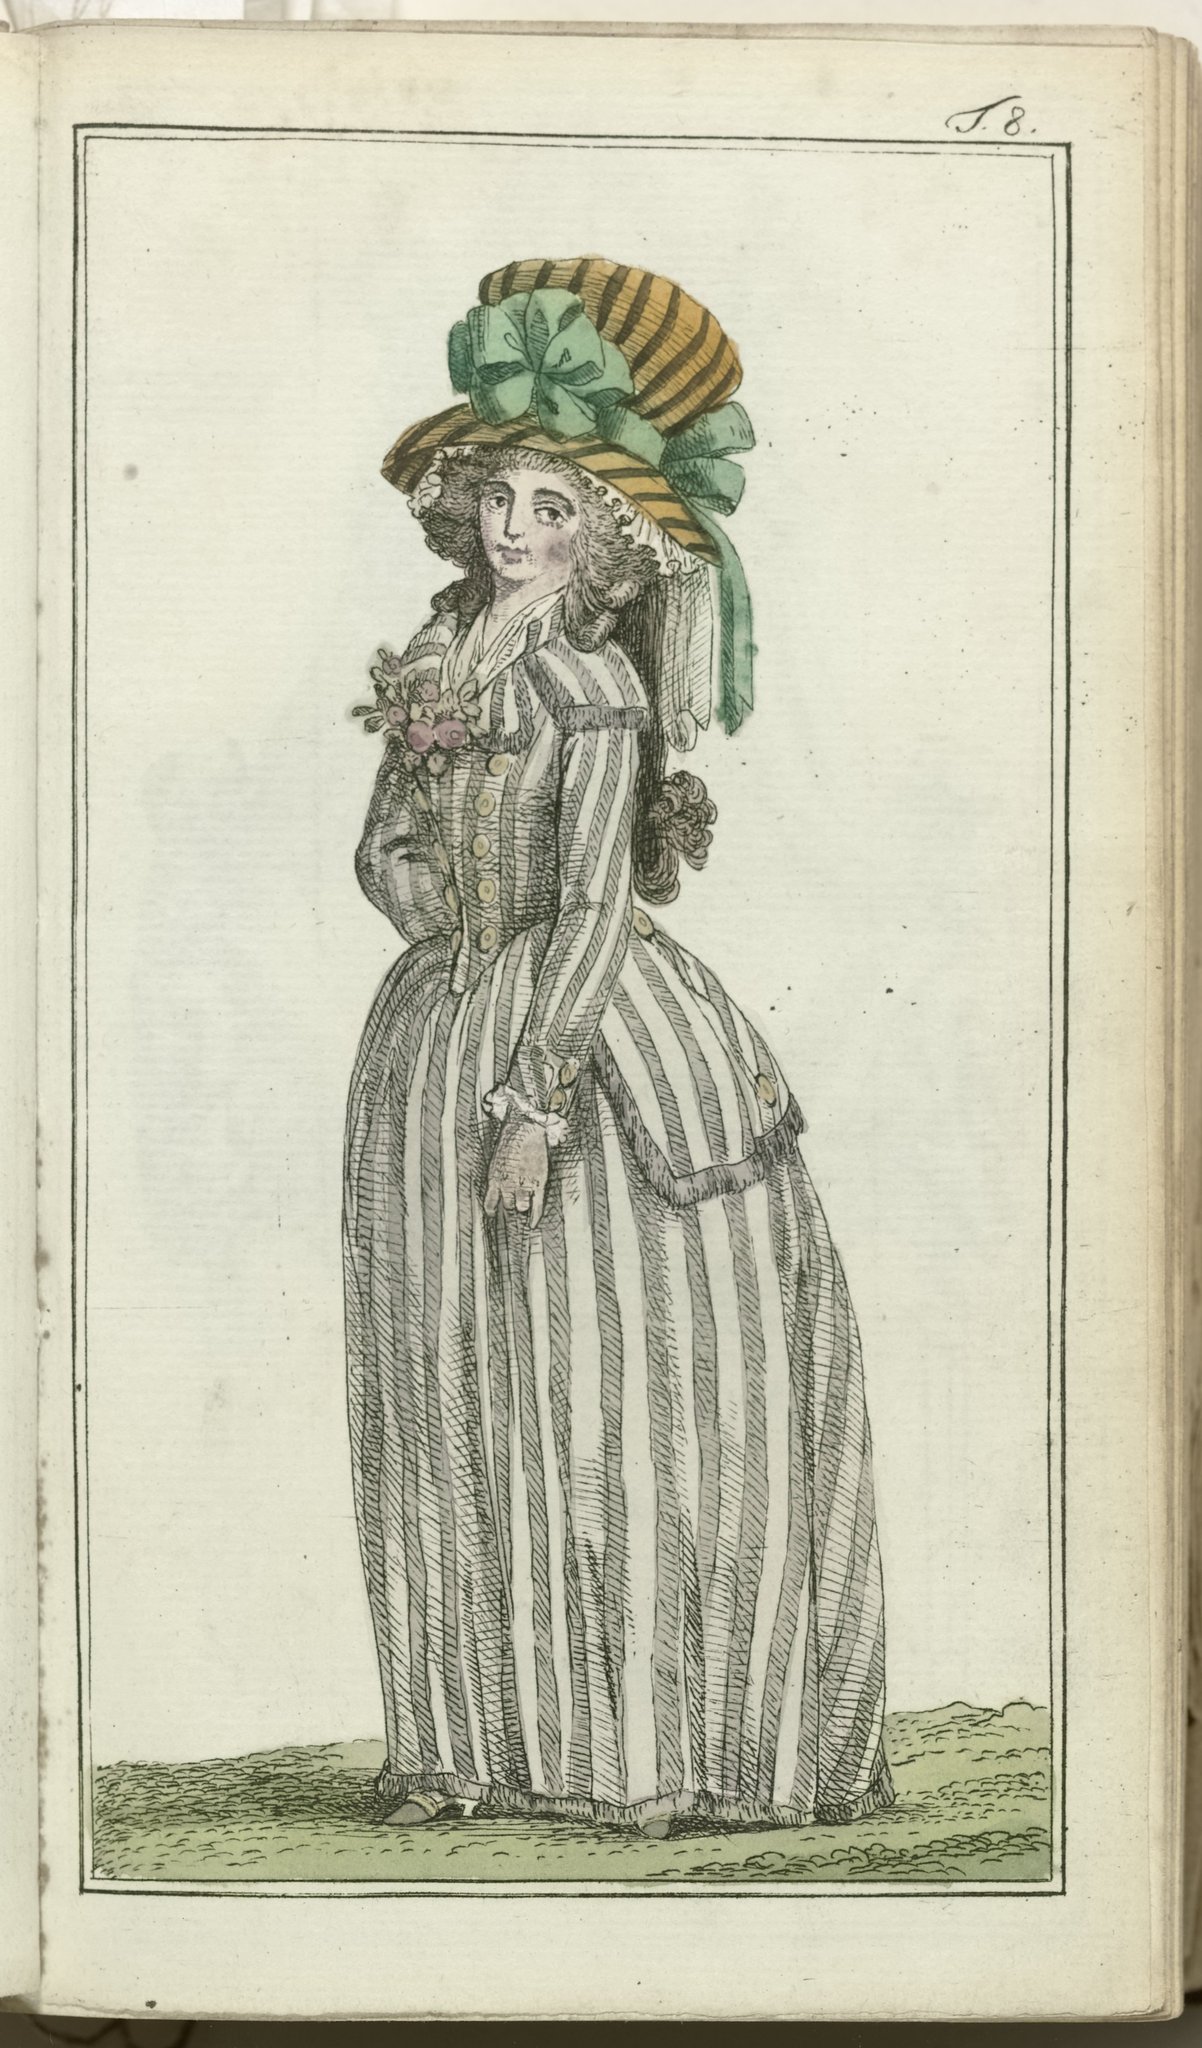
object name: fashion print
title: Journal des Luxus und der Moden 1788, Band III, T.8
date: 1788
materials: paper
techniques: etching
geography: weimar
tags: fashion plates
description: Vrouw uit Parijs met een Engelse "Morning Hat" (hoed voor de ochtend) met groen lint en grote strik. Gekleed in een "Veste longue à Corsage busqué' en een rok van zebra-stof of "Drap Zèbre", een nieuwe stof die in Parijs net in de mode is. Schoenen `à la claque' Prent uit het modetijdschrift Journal des Luxus und der Moden, uitgegeven door Friedrich Justin Bertuch en Georg Melchior Kraus, Weimar, 1786-1826.